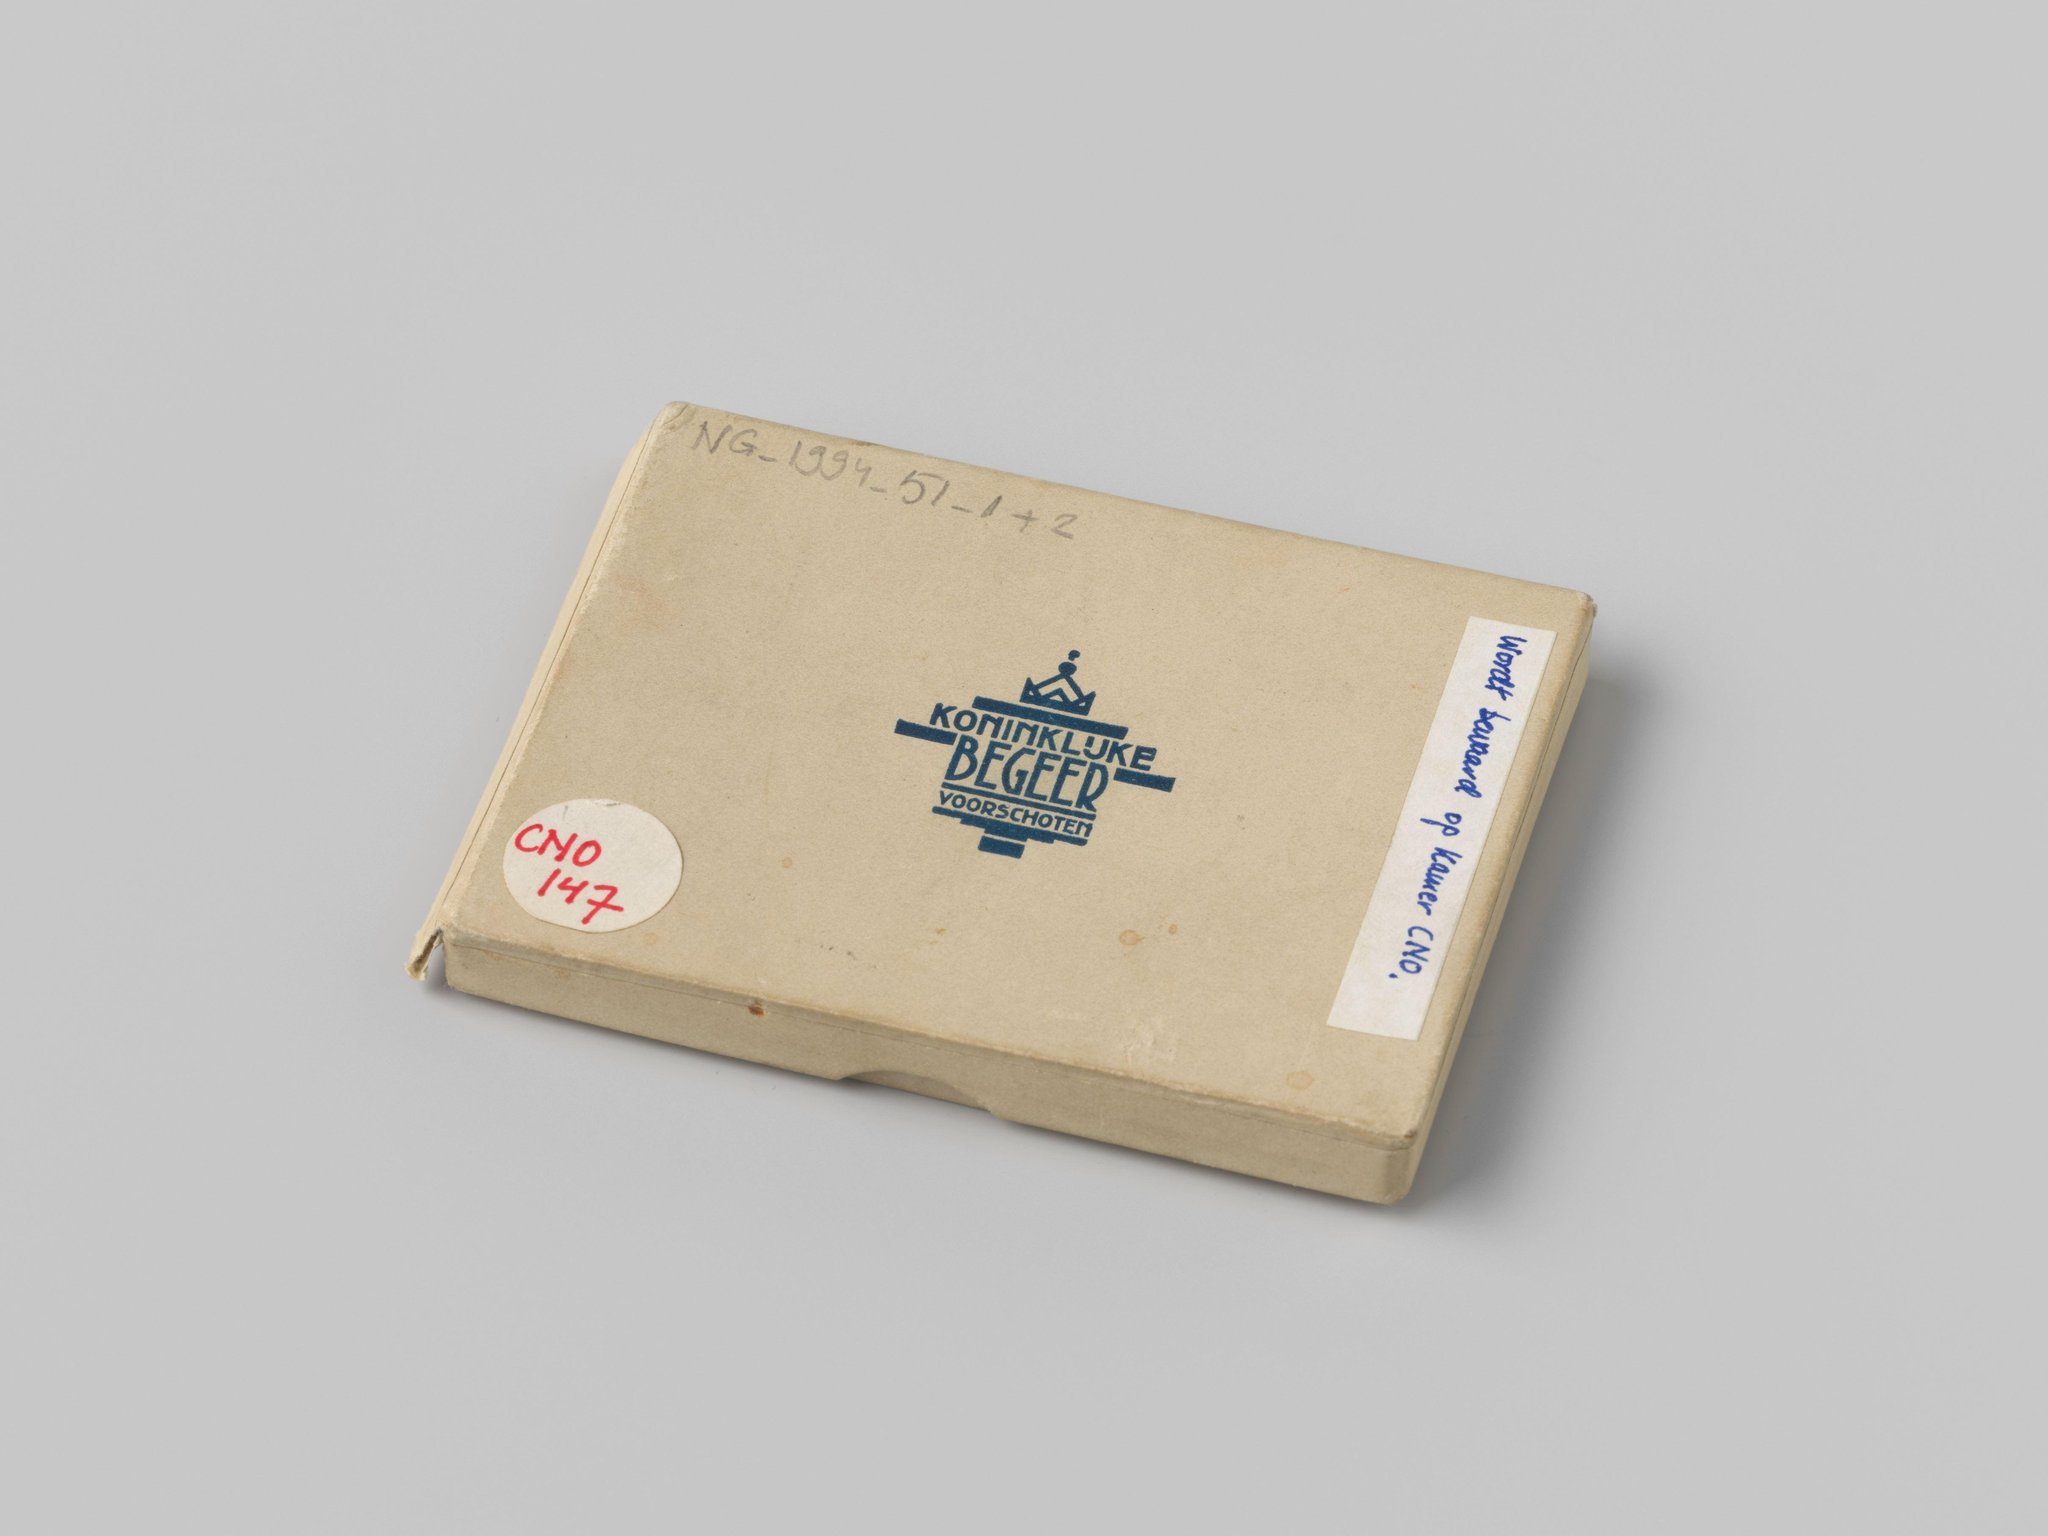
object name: medal box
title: Doos behorend bij plaquette F.J. Fuchs en Rens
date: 1936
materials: cardboard, velvet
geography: voorschoten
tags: voorschoten, dutch east indies, the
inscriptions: mark: ‘KONINKLIJKE / BEGEER / VOORSCHOTEN’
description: Wit kartonnen doosje met op het deksel een opschrift in blauw. Binnenzijde van het deksel voorzien van paars fluweel.